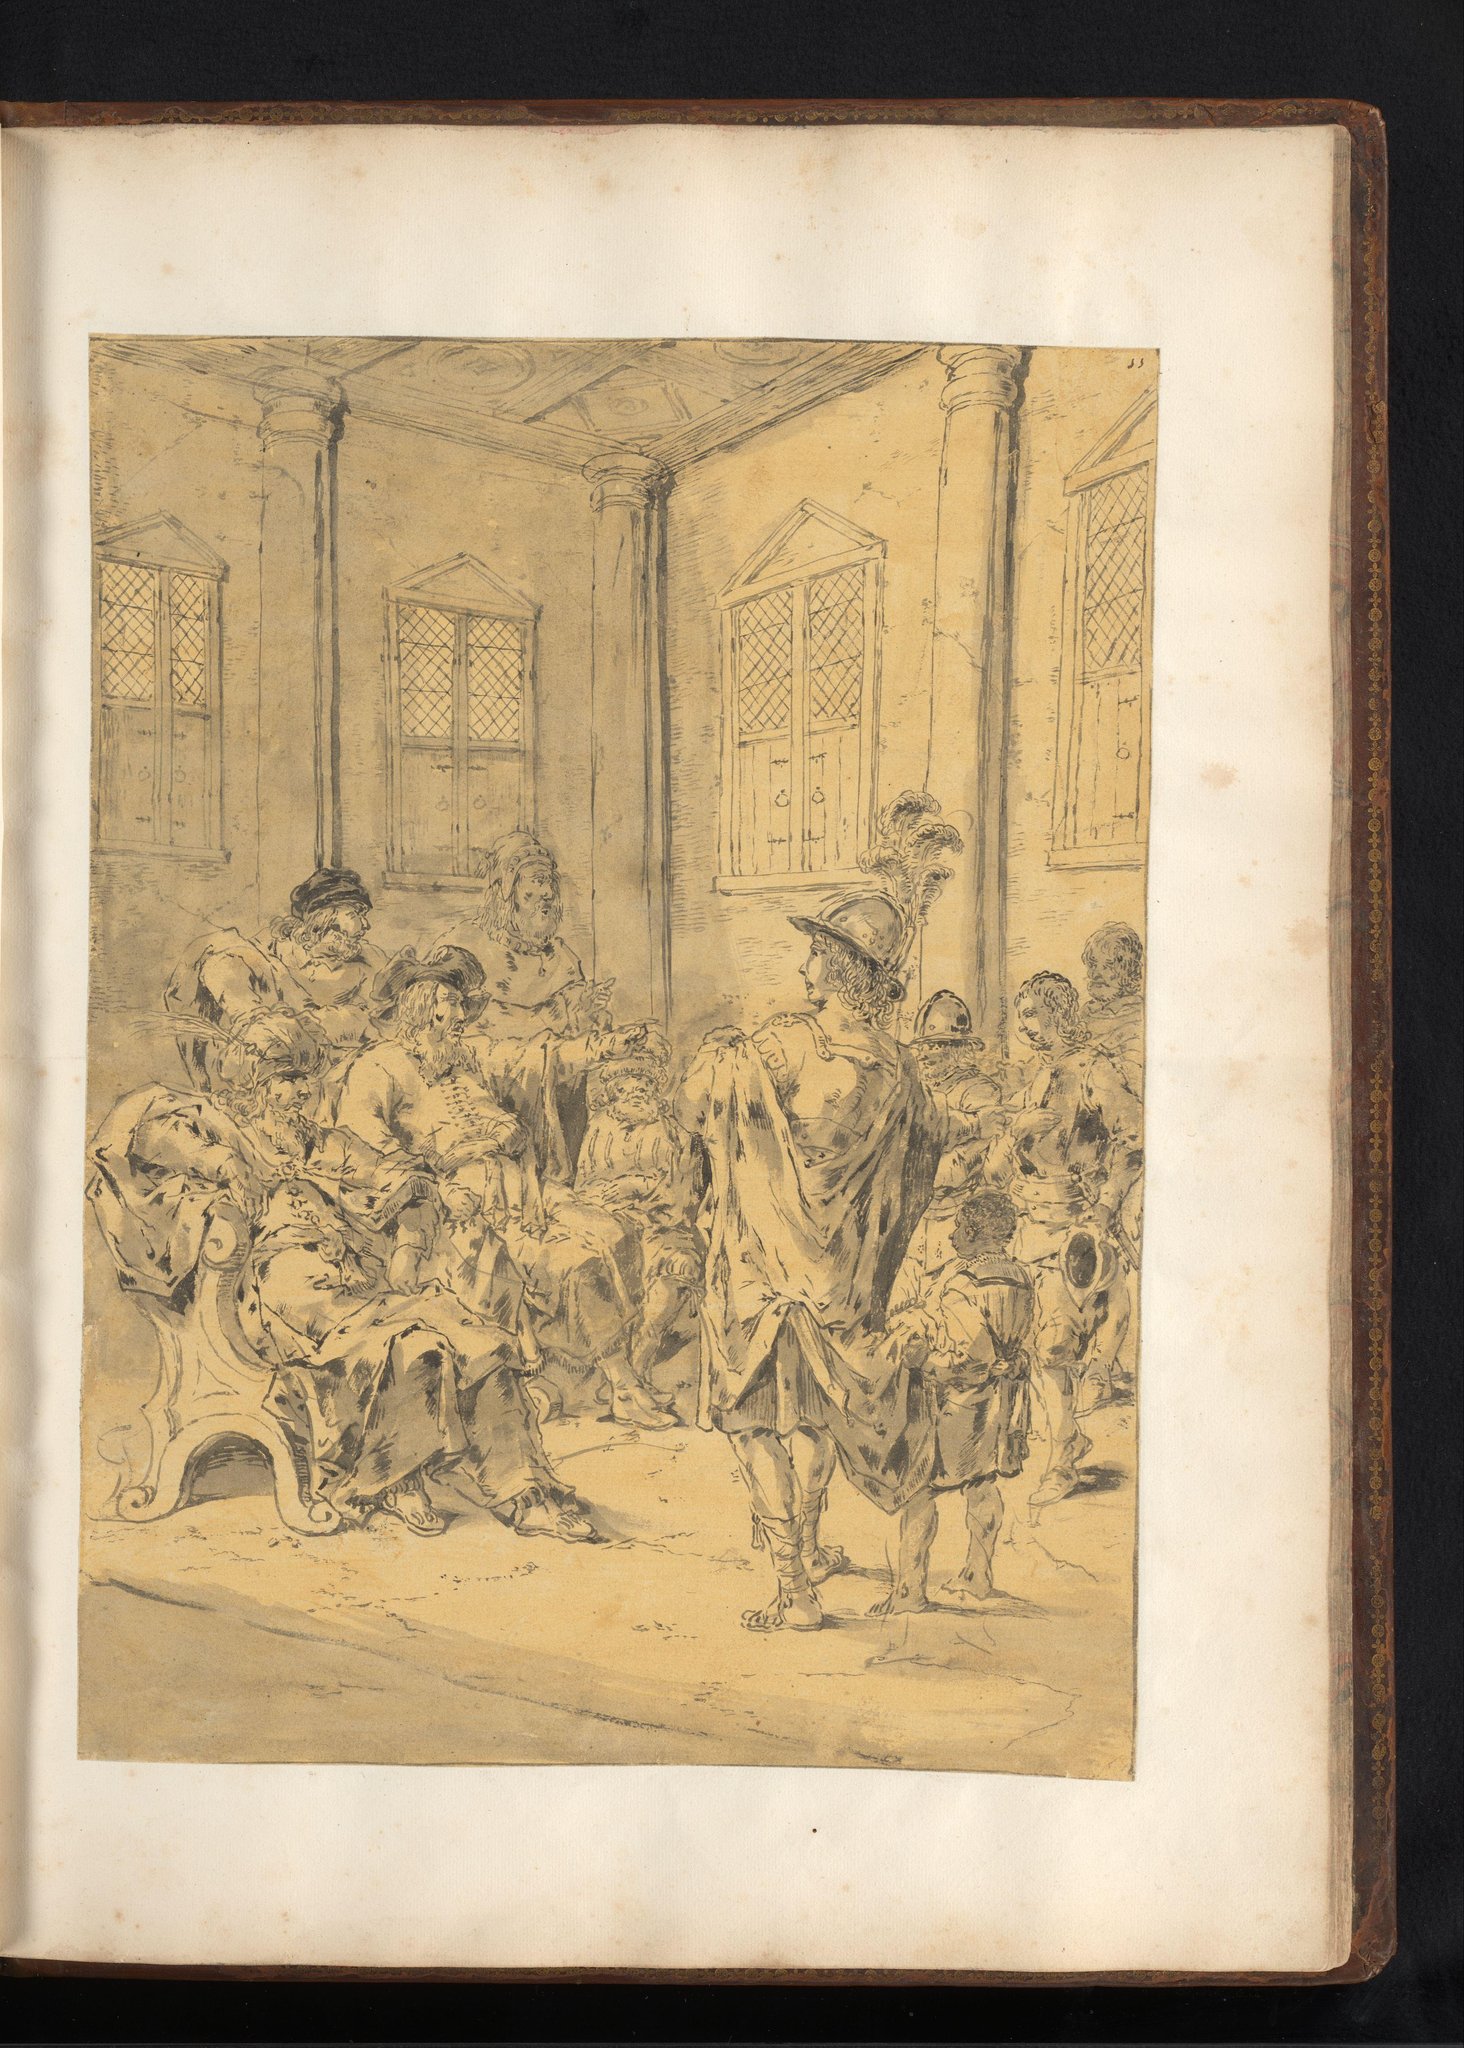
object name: drawing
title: Alexander de Grote wordt verkozen tot opperbevelhebber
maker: leonaert bramer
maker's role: draughtsman, painter, print maker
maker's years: 1596-1674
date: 1655-1665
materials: ink, paper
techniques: brush, pen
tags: (story of) alexander the great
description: Alexander de Grote wordt tijdens een vergadering door de Grieken verkozen tot opperbevelhebber in de strijd tegen de Perzen. Rechtsboven genummerd: 11. Tekening maakt deel uit van een album.